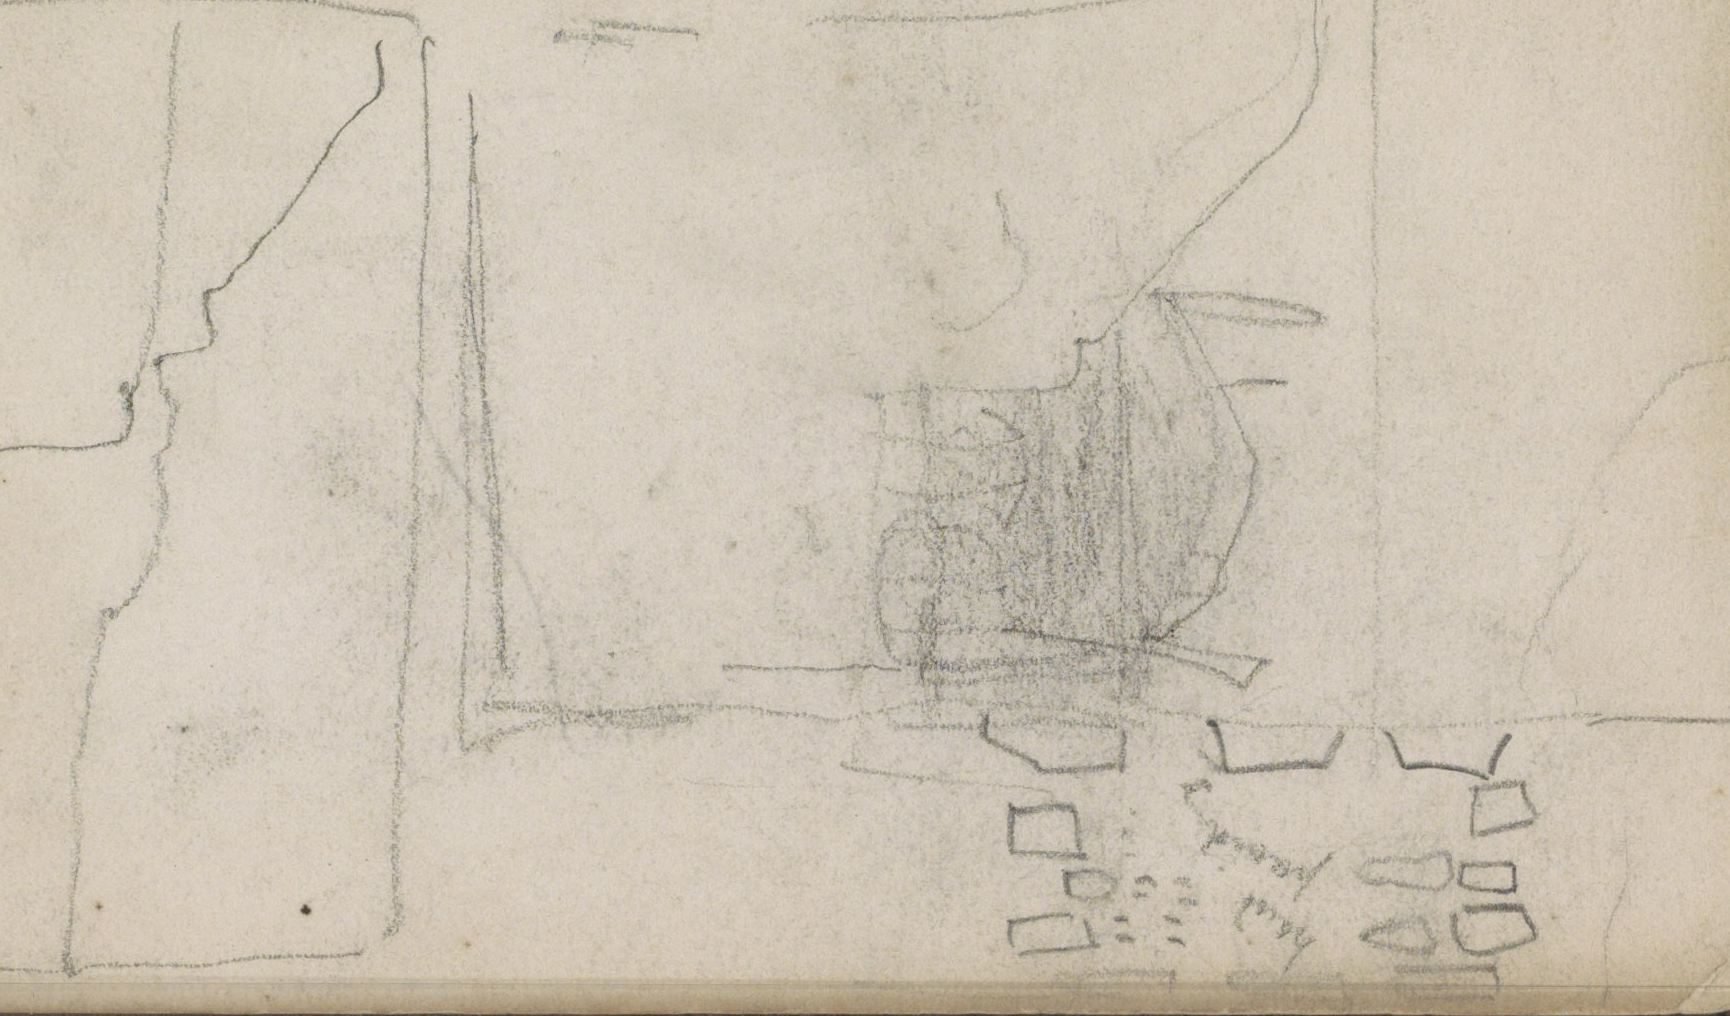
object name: sketchbook leaf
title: Compositiestudies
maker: george hendrik breitner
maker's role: draughtsman, painter, print maker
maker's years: 1857-1923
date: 1881-1883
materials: paper, pencil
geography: north brabant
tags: landscapes, civic architecture; edifices; dwellings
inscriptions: annotation: ‘[...]/ paard[...]’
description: Pagina 82 uit een schetsboek met 42 bladen.